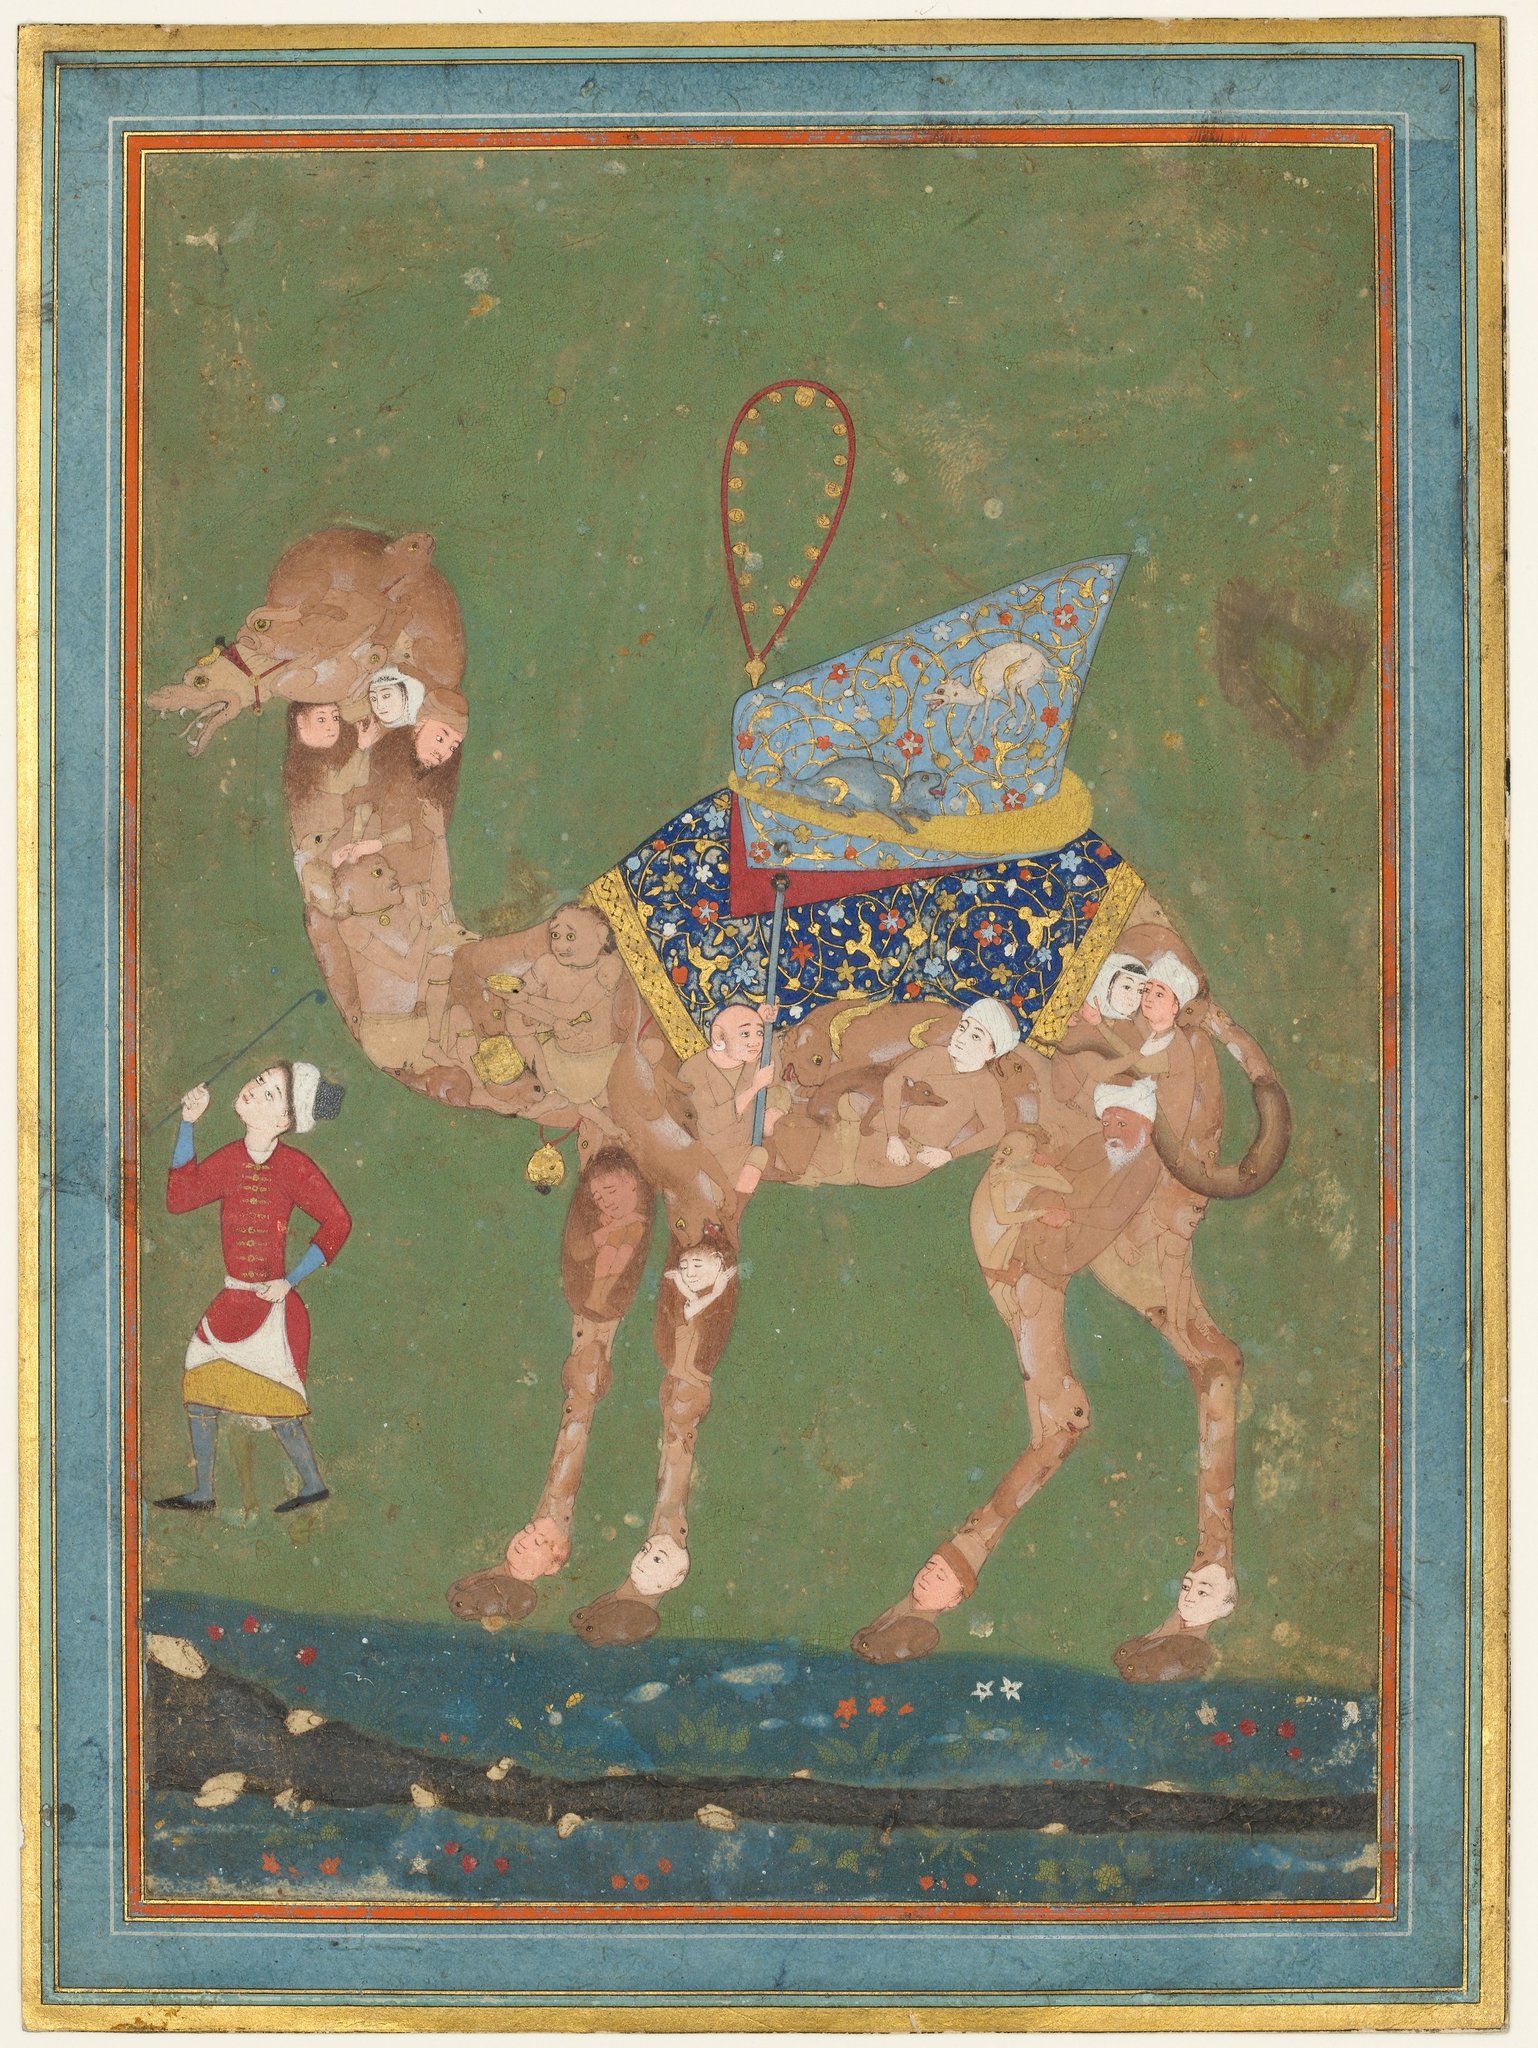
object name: illustrated single work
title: Composite Camel with Attendant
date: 1551-1575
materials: ink, paper, watercolor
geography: iran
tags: men,camels